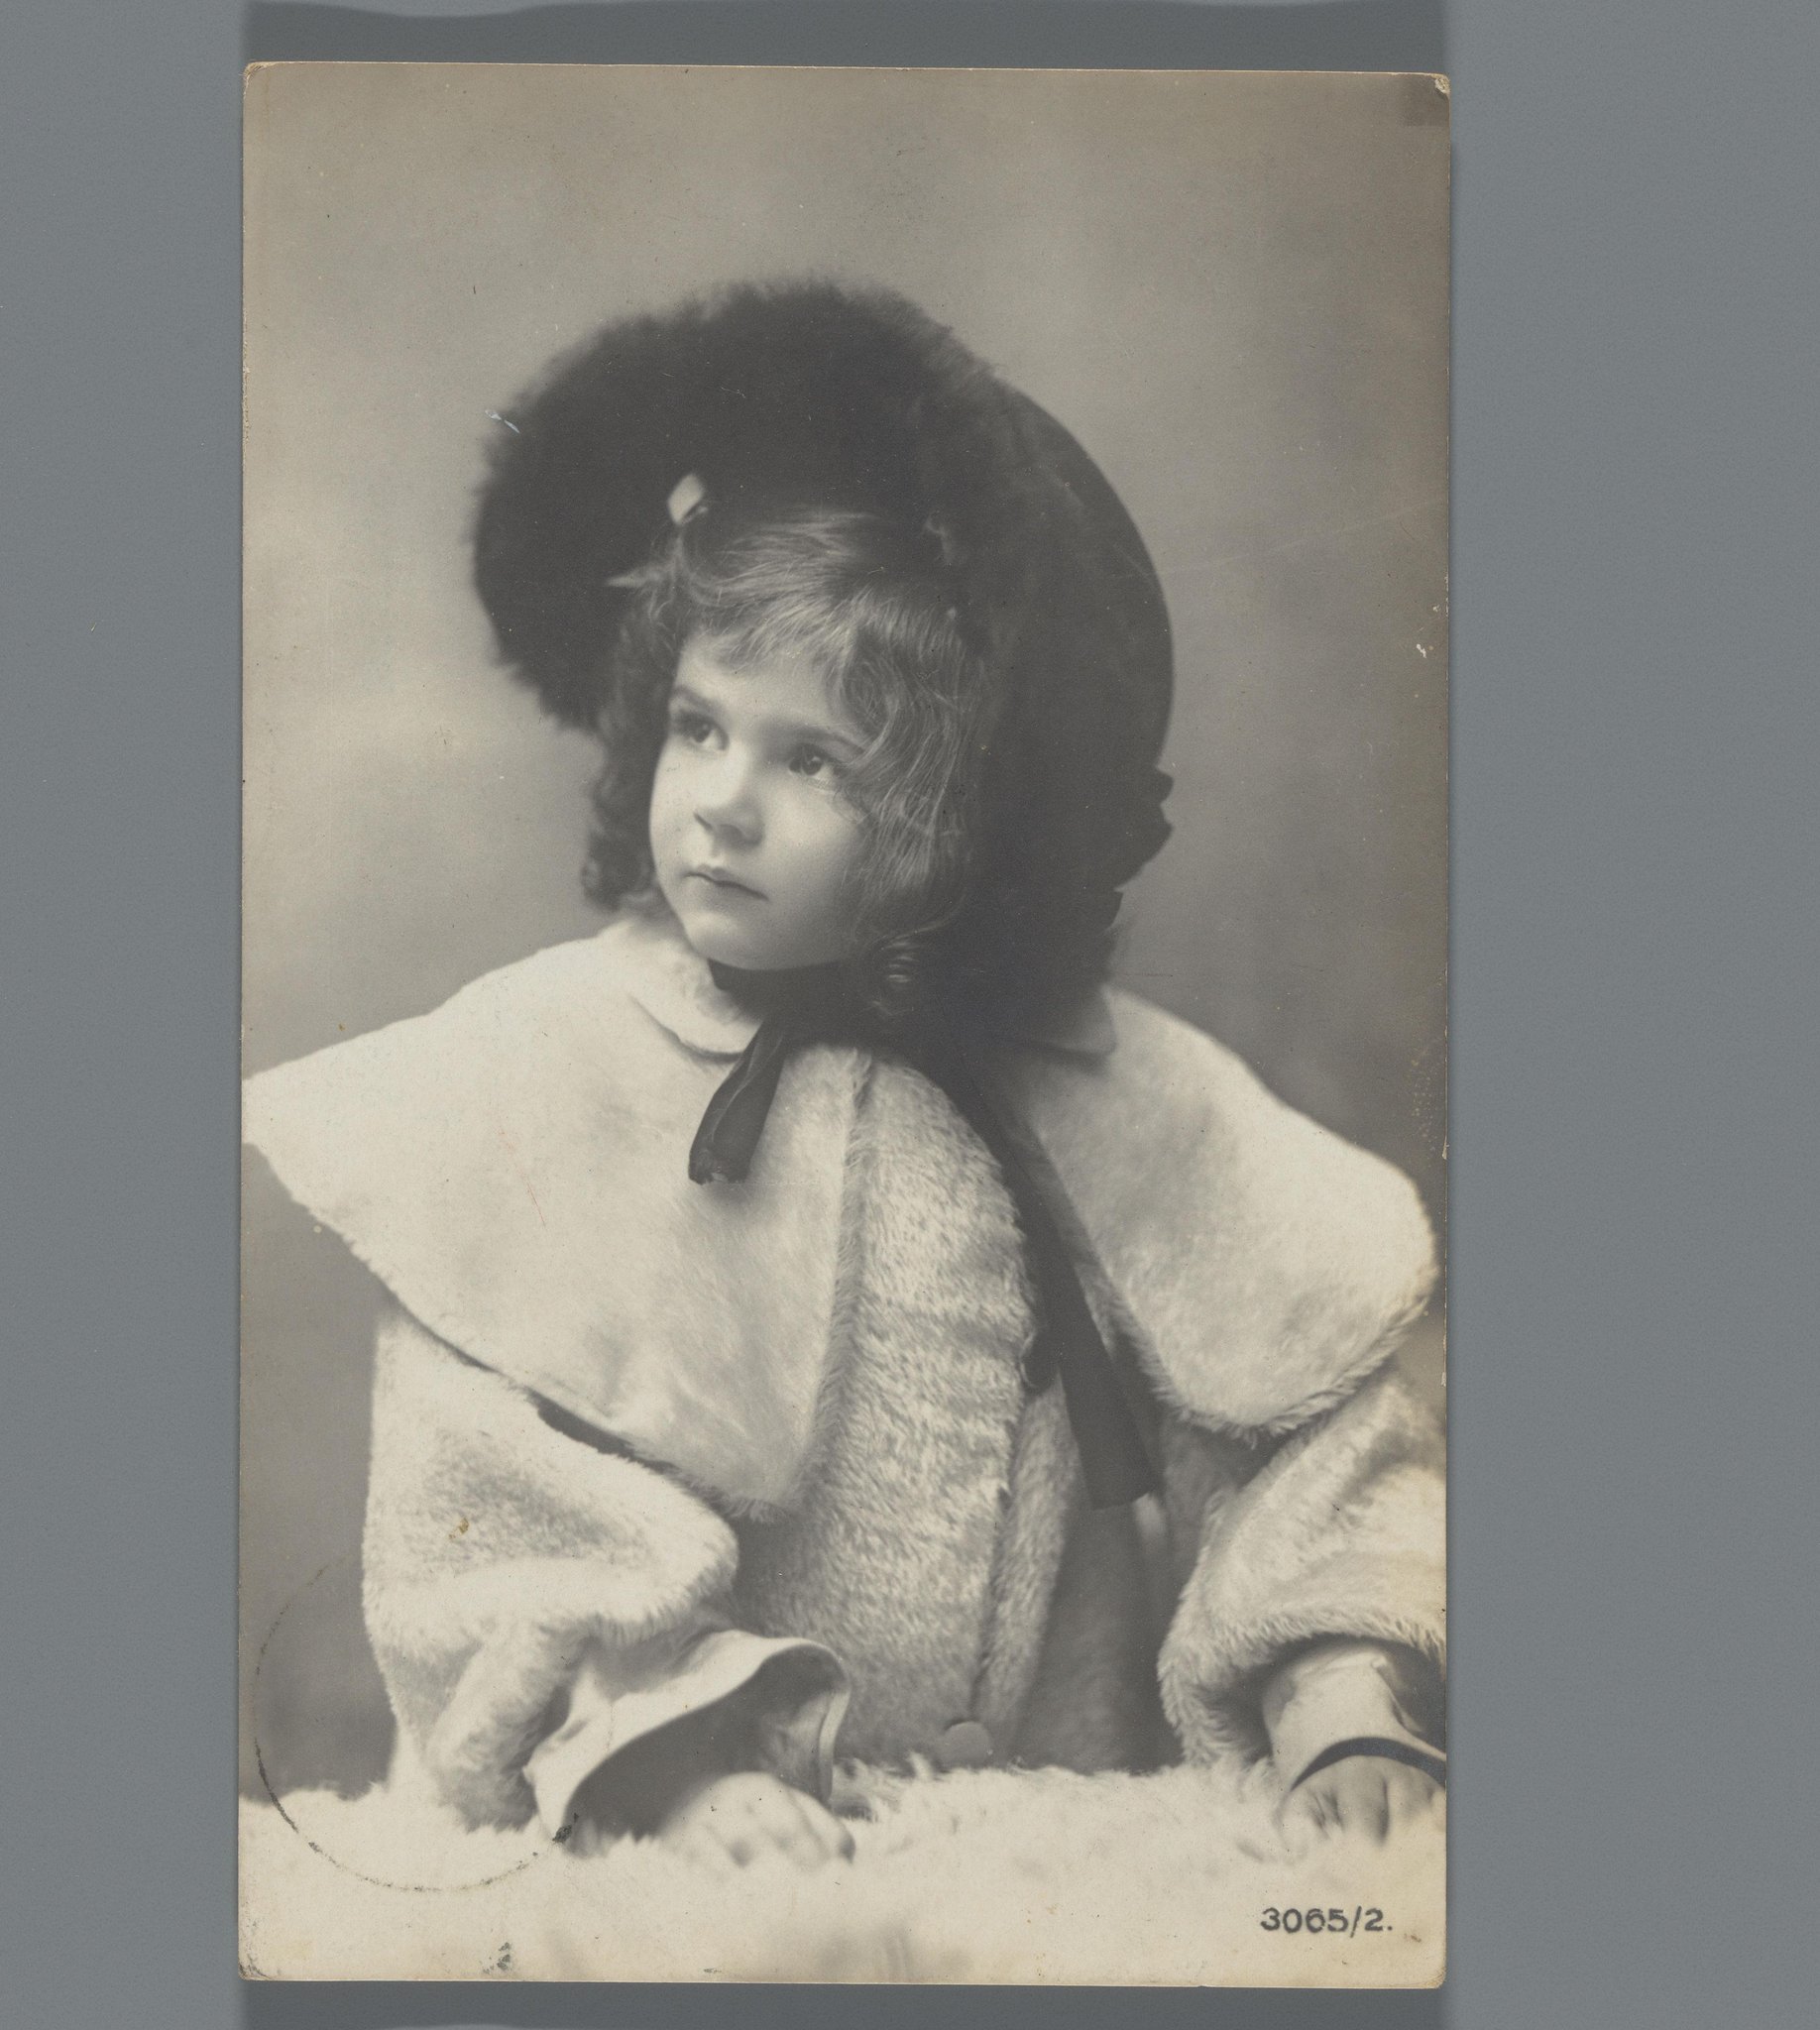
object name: ansichtkaart, prentbriefkaart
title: Portret van een onbekend meisje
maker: Anonymous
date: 1905-1910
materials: paper, ink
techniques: gelatin silver print, pen, writing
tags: girl (child between toddler and youth), anonymous historical person portrayed - bb - woman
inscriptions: inscription: ‘M/ A. van Aalst/ p/a/ Den Welld. Heer Sillevis/ Kerk-Avezaath’